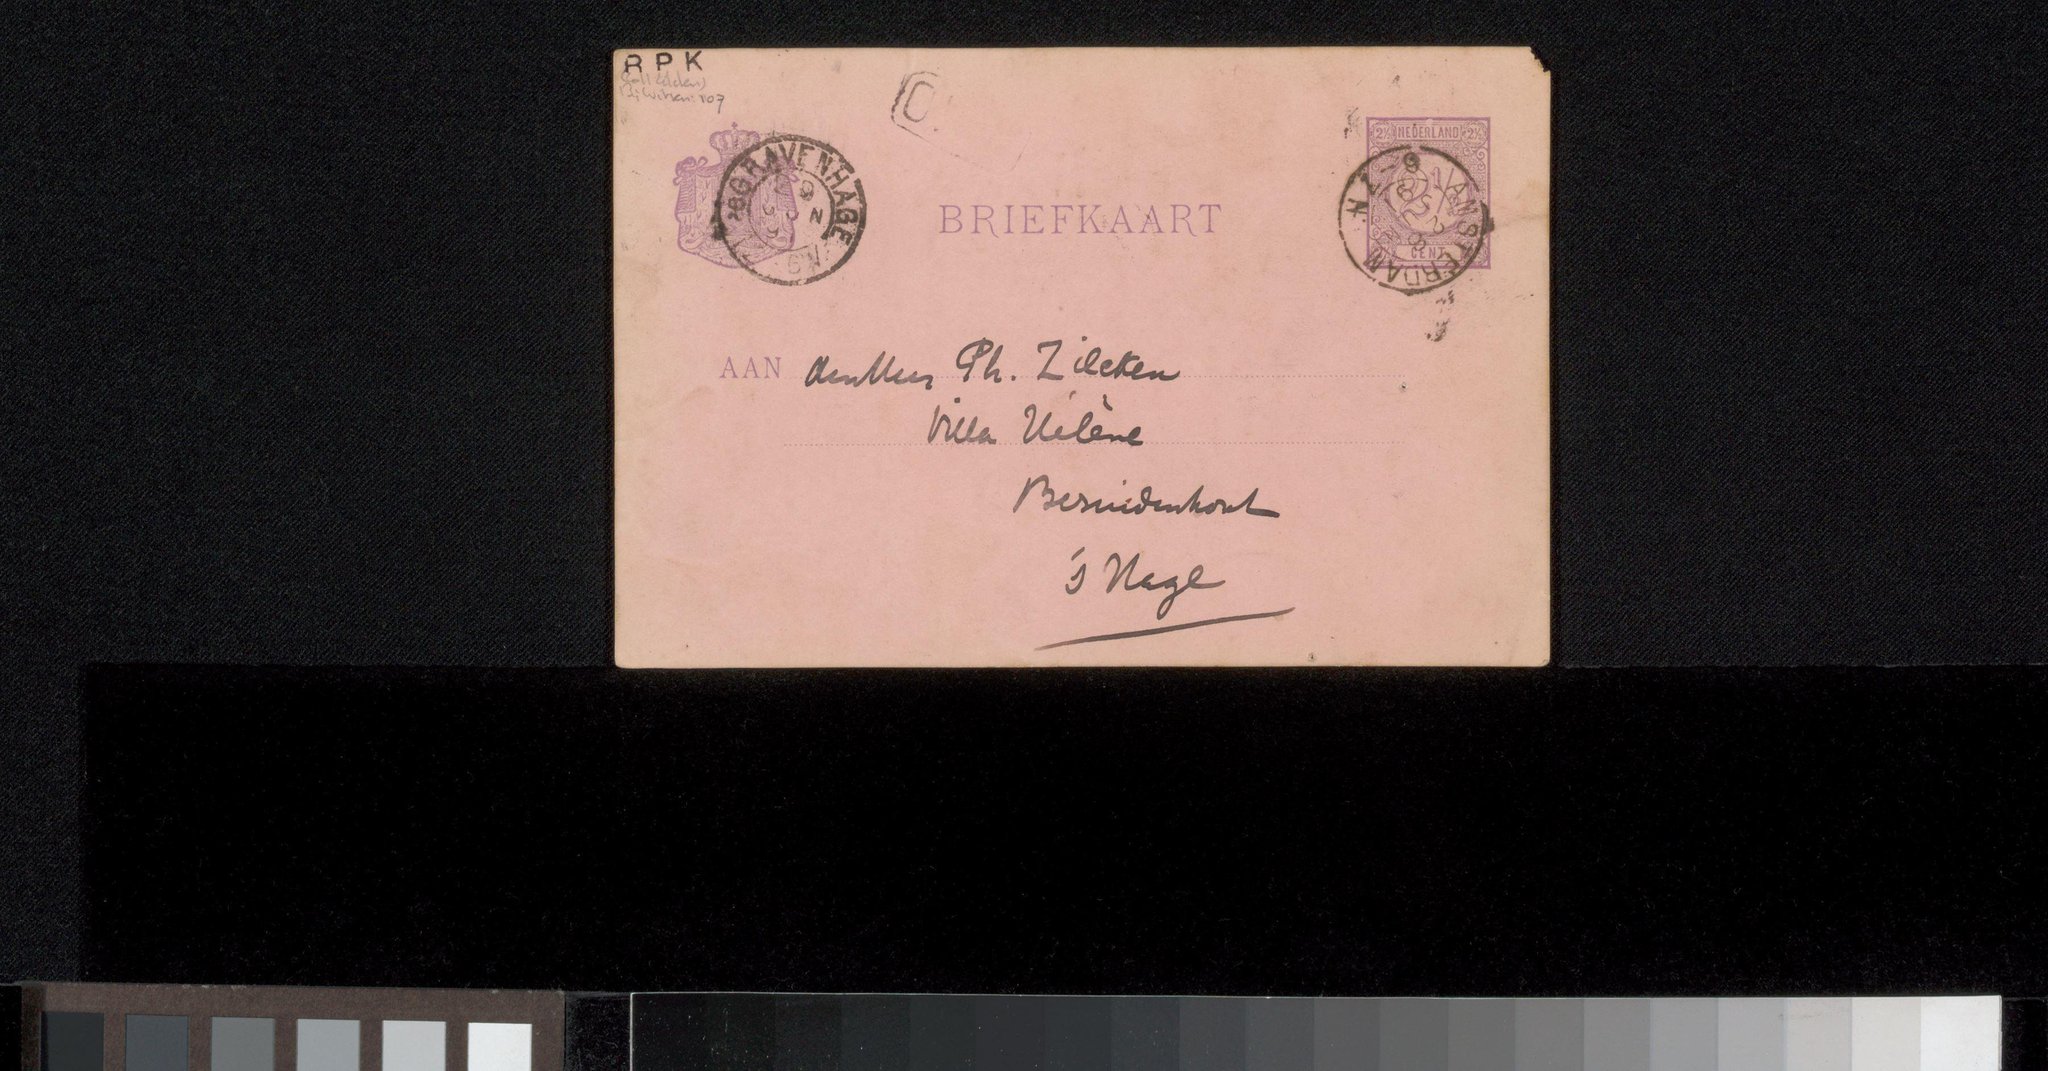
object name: postcard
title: Briefkaart aan Philip Zilcken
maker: willem witsen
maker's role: draughtsman, painter, print maker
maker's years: 1860-1923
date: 1891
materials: cardboard, ink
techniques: pen, writing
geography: amsterdam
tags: printer, joseph bouwens, frederick keppel, the hague, philip zilcken, the graphic arts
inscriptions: collector's mark: ‘RPK’